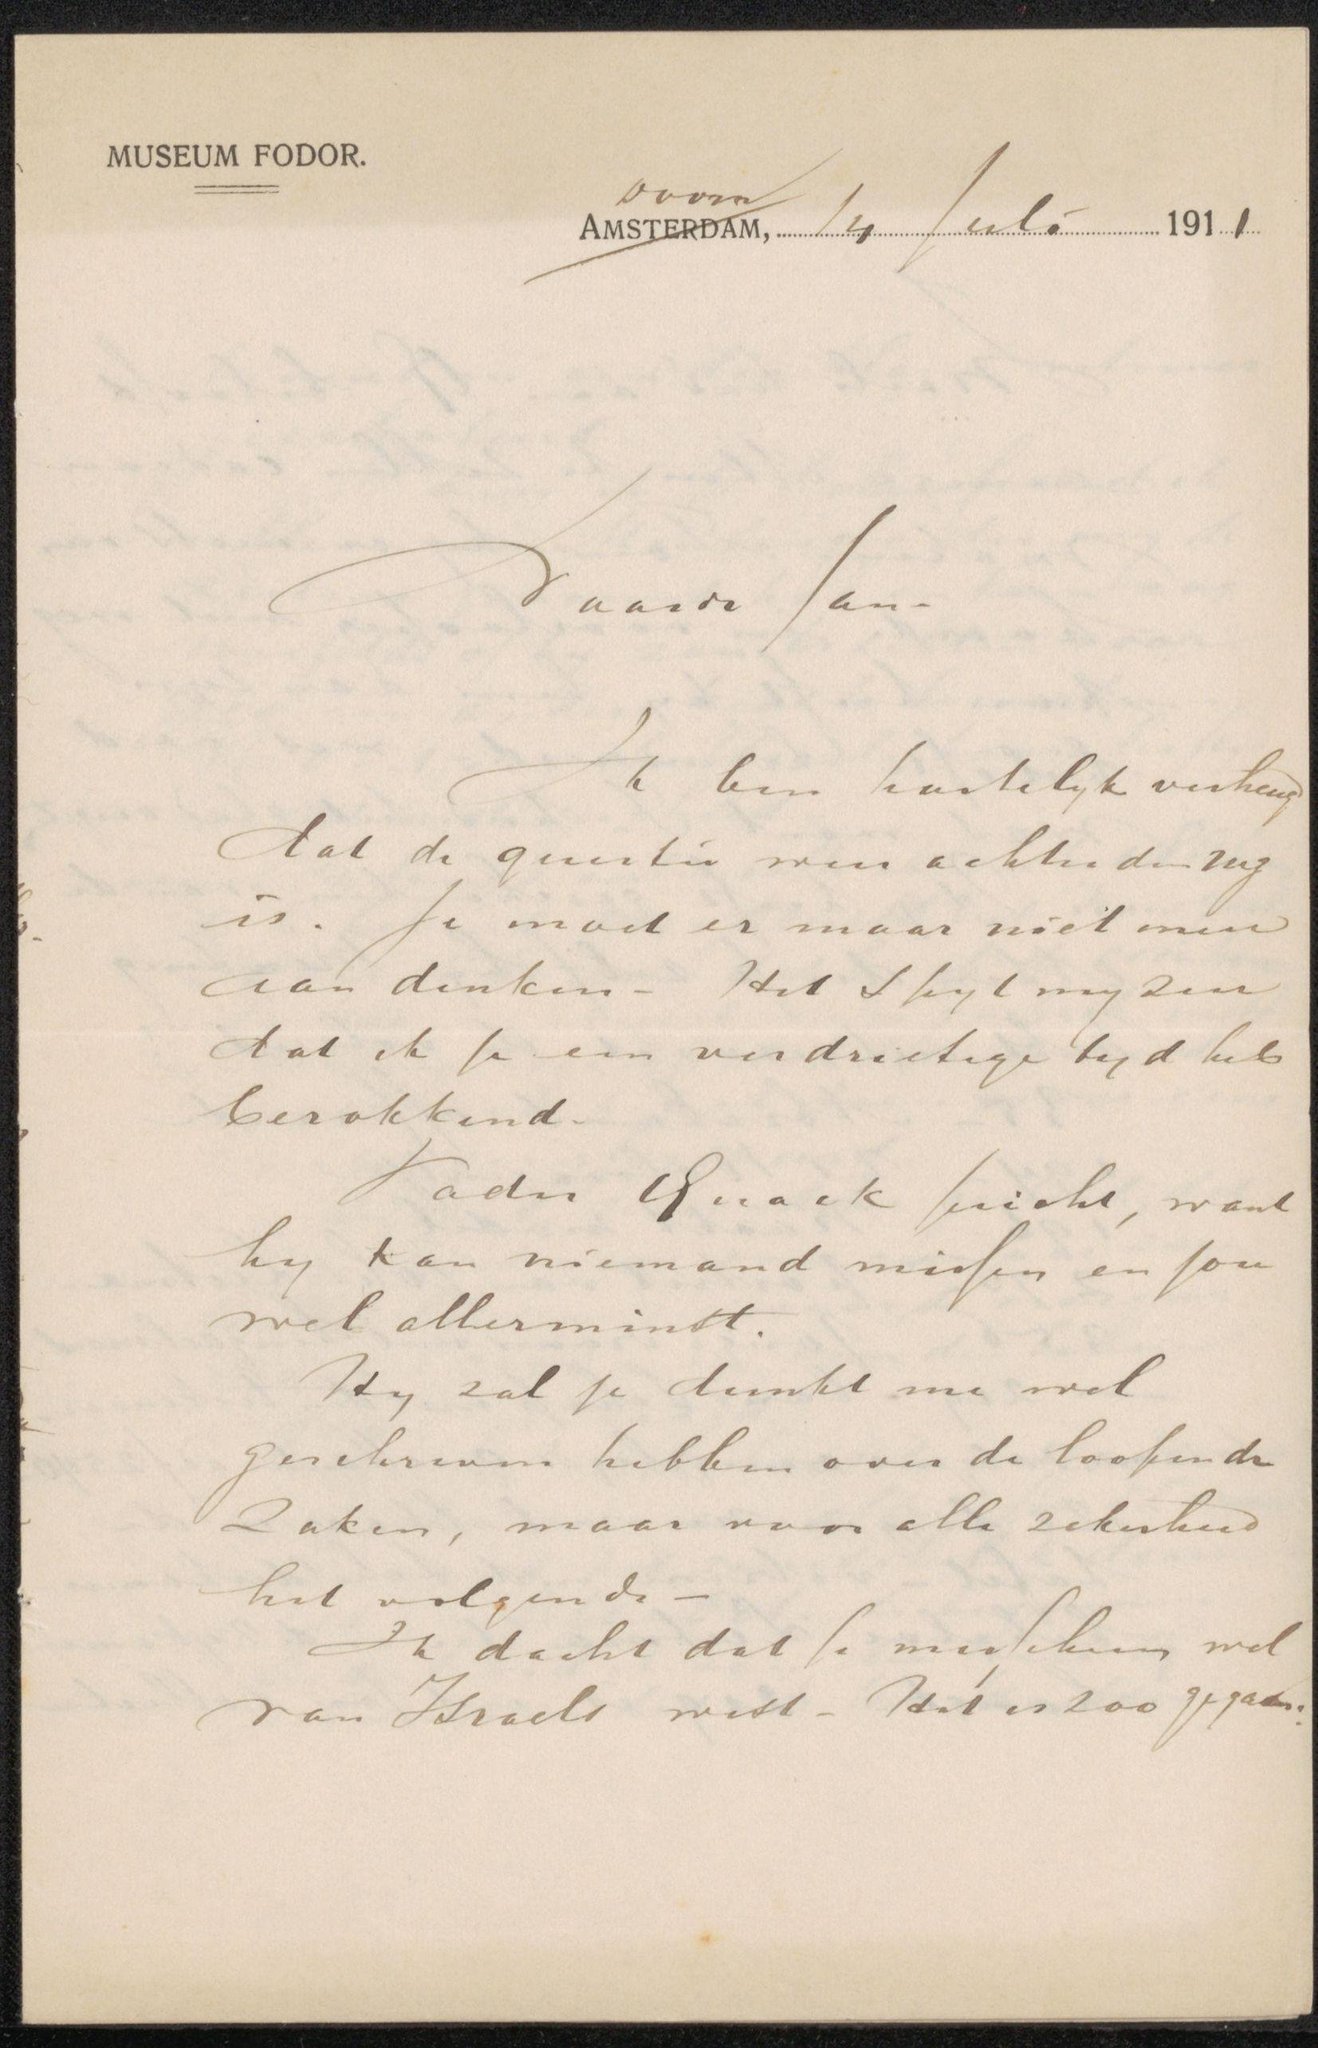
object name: letter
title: Brief aan Jan Veth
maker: cornelis gerardus t hooft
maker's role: draughtsman, painter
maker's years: 1866-1936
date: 1911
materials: ink, paper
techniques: pen, printing, writing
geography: doorn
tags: the hague, jozef israëls, print maker, designer, jan veth, antonius wilhelmus mari mensing, hendrick peter godfried quack, silversmith, johannes lutma (1584-1669), art trade, art shop, the graphic arts, money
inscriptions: collector's mark: ‘RPK’